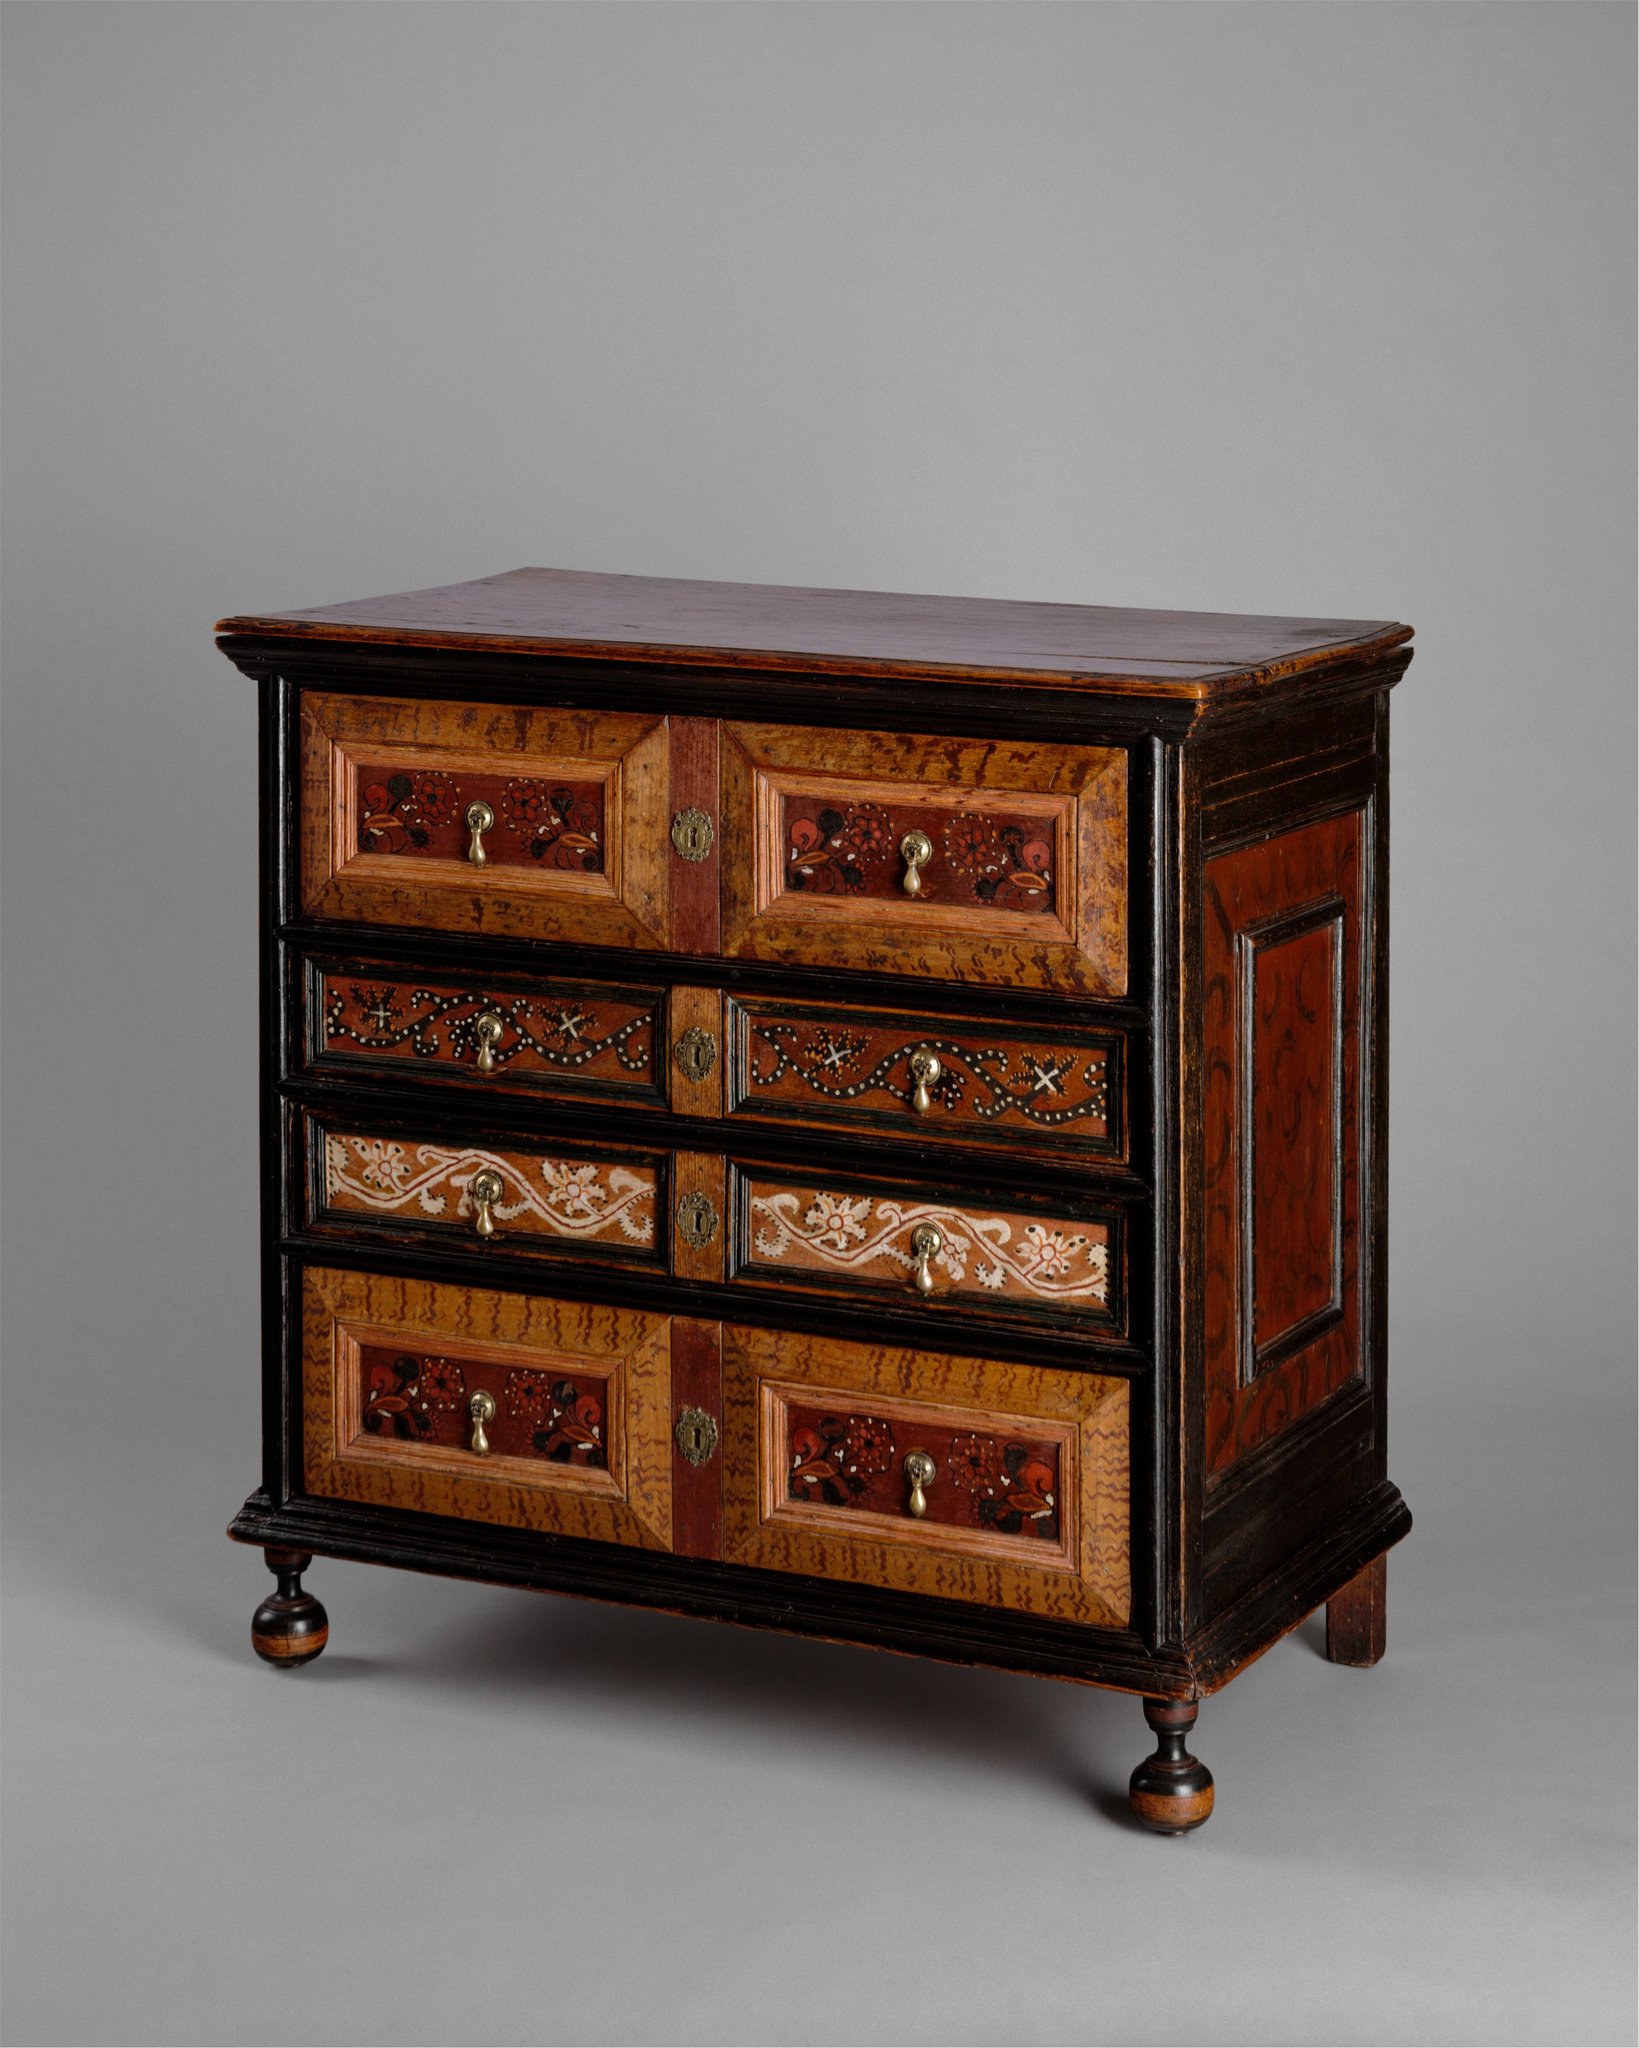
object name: chest of drawer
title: Chest of Drawers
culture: american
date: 1700-1720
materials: wood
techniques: painting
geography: united states